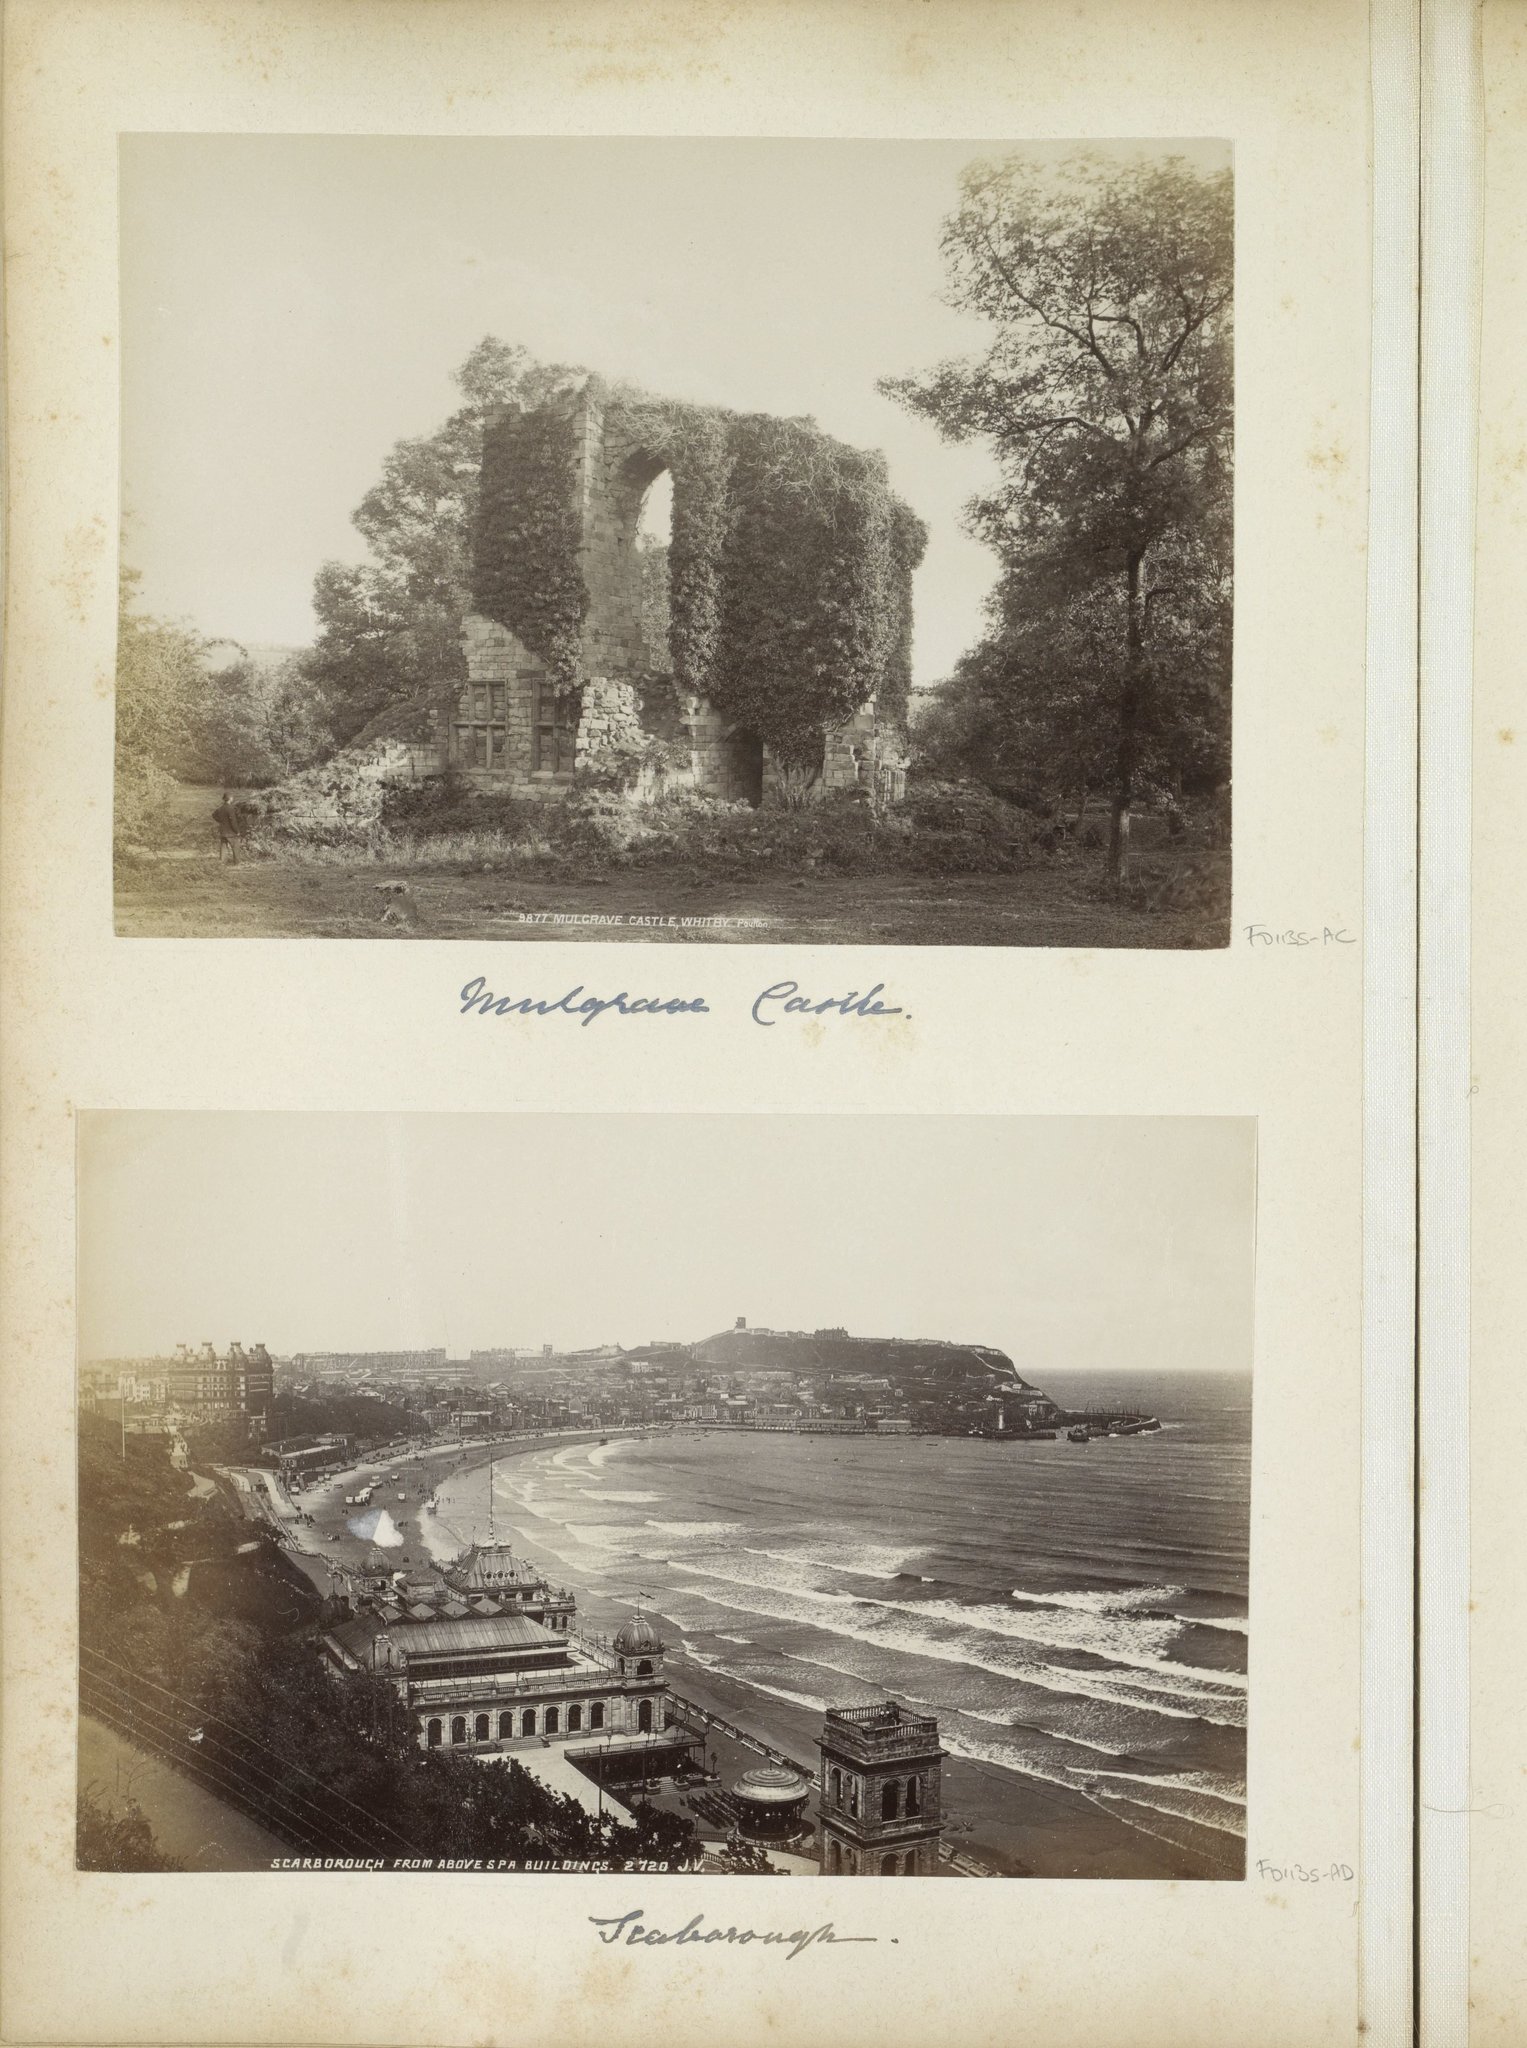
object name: photograph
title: Overwoekerde ruïne van Mulgrave Castle in Whitby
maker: poulton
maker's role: fotograaf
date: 1898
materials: paper, photographic support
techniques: albumen print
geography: whitby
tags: ruin of a dwelling, house, castle, etc.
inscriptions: number: ‘9877’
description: Onderdeel van Reisalbum met foto's van bezienswaardigheden in Engeland en Frankrijk.